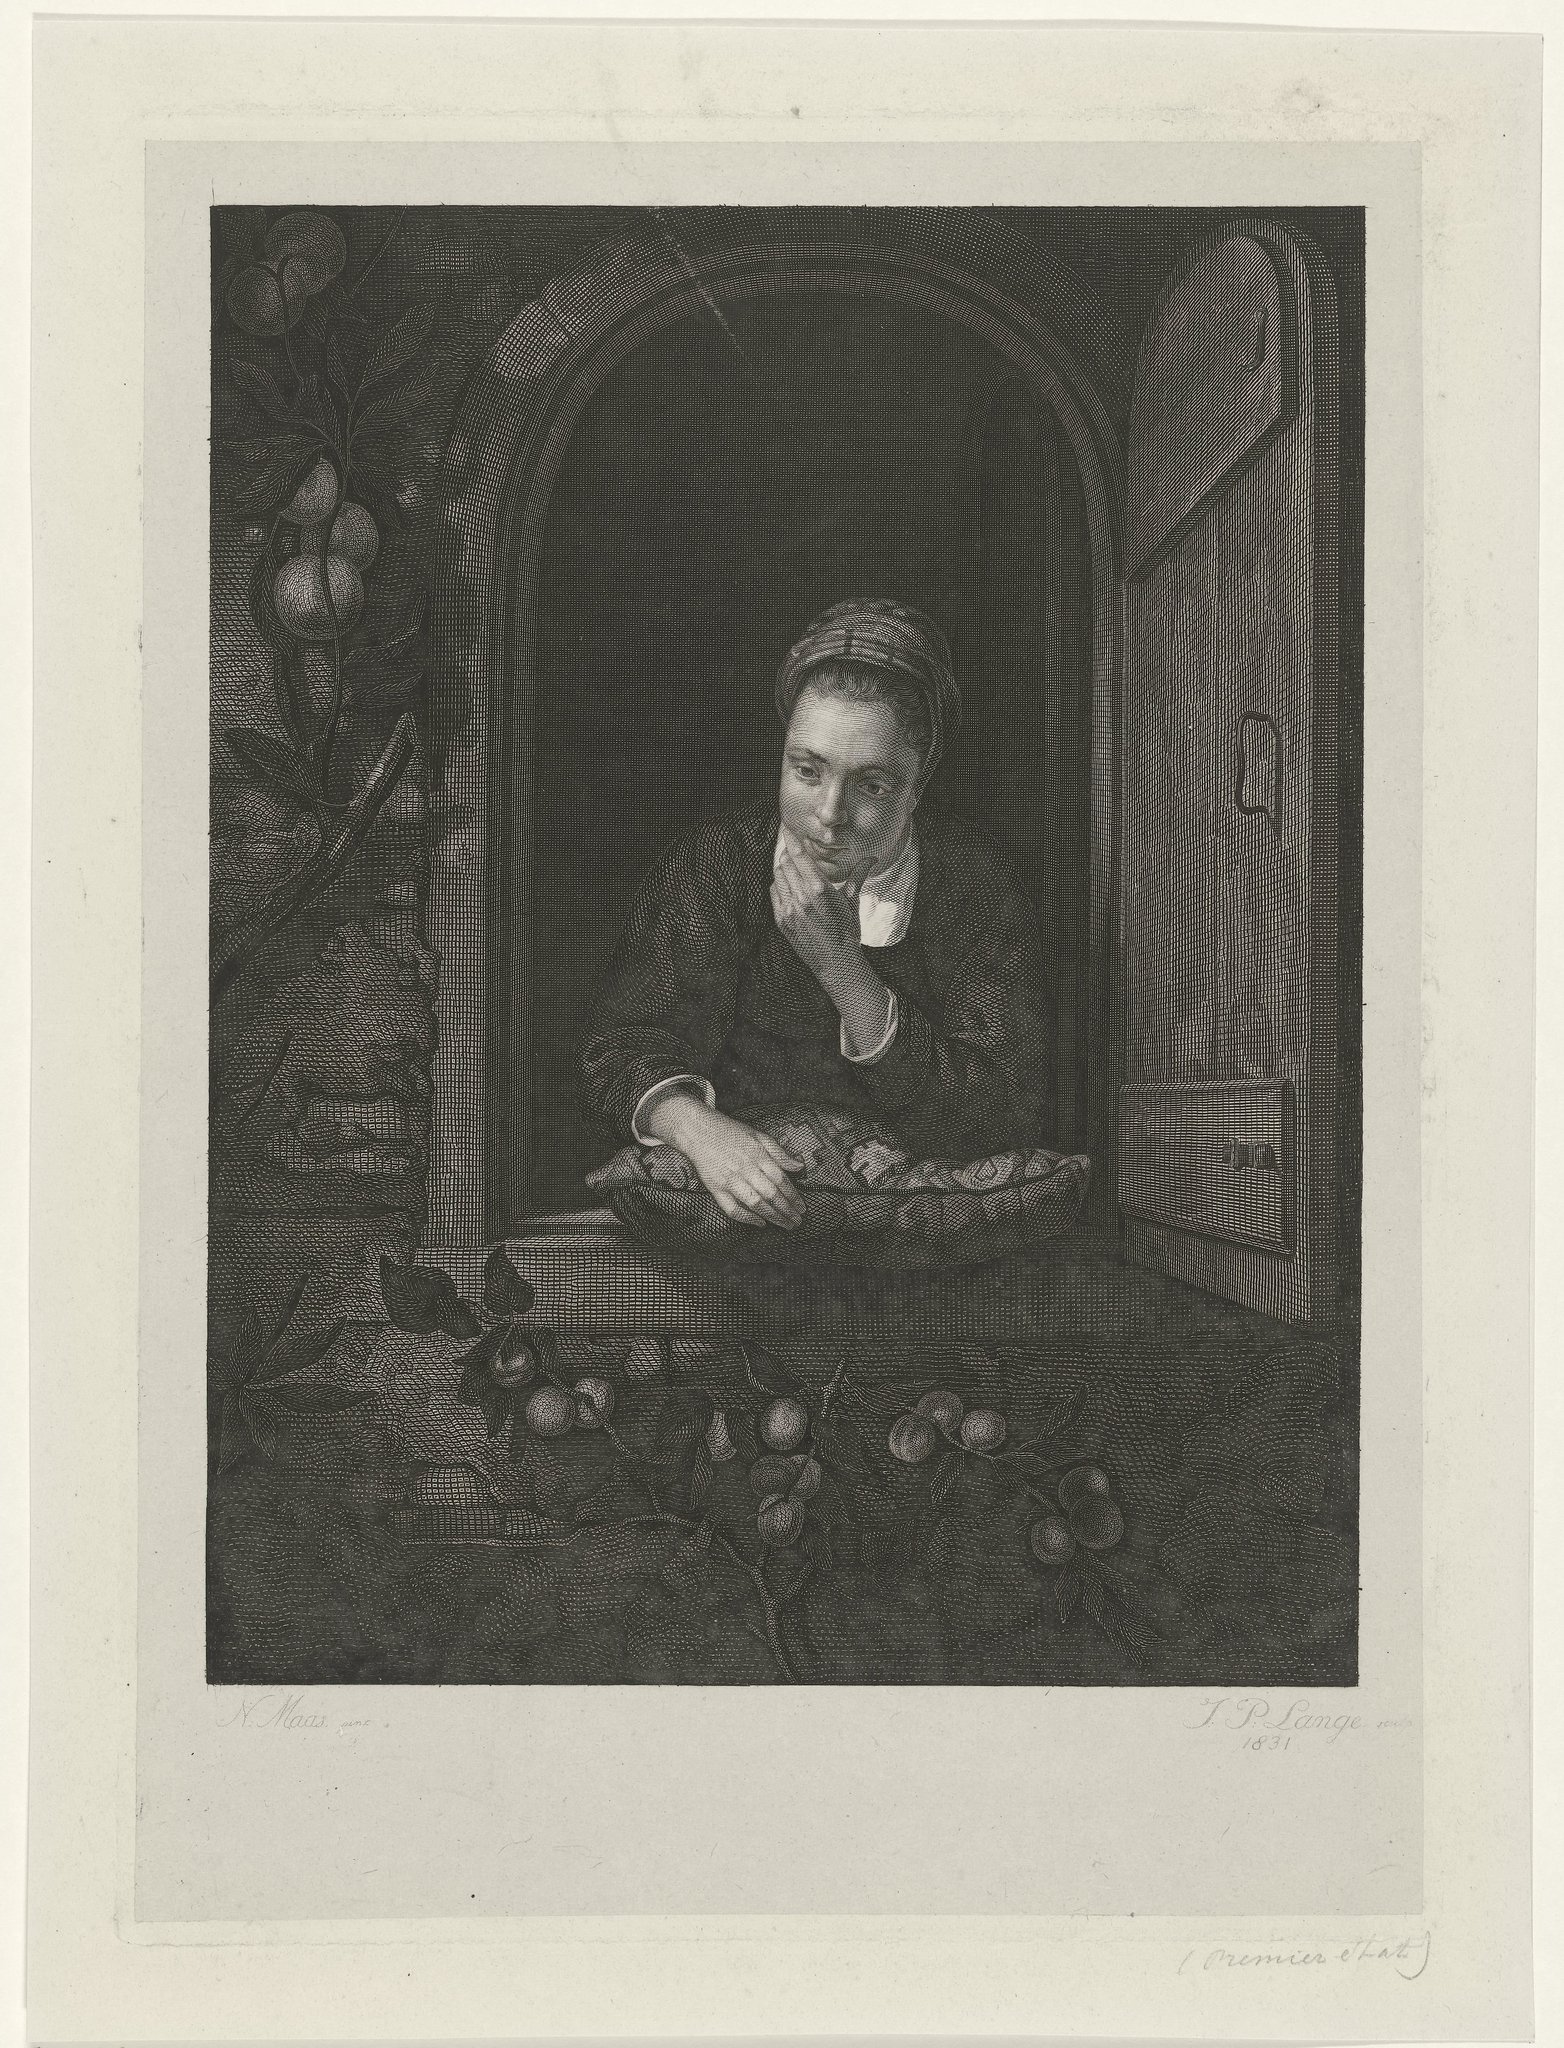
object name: print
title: Meisje aan het venster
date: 1831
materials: paper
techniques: engraving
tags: adolescent, young woman, maiden, window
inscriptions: collector's mark: Lugt 2228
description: Een meisje aan het venster, bekend onder de titel 'De peinzende'. Het meisje leunt op een kussen dat in het venster ligt, met haar linkerhand ondersteunt ze haar kin. Rechts het openstaande luik van het venster. Tegen de muur van het huis groeit een abrikozenboom.